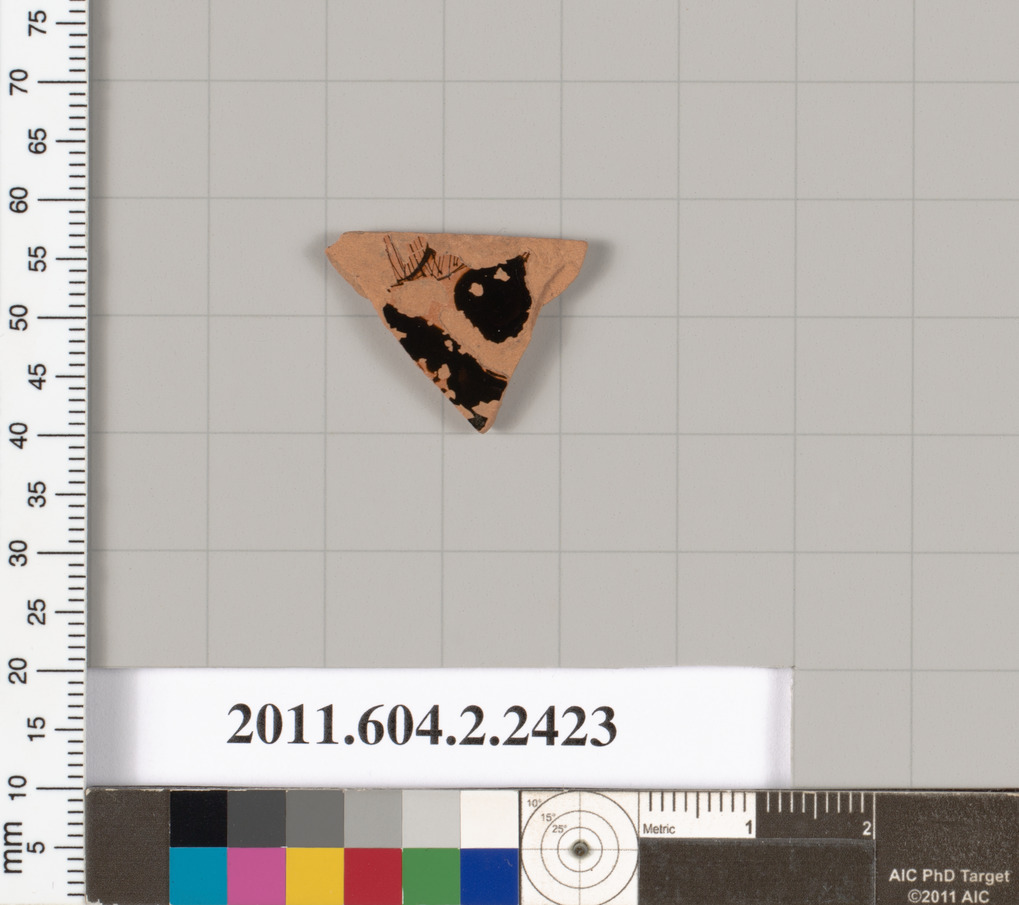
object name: undetermined closed shape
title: Terracotta fragment of a closed shape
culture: greek, attic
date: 480-470 BCE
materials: terracotta